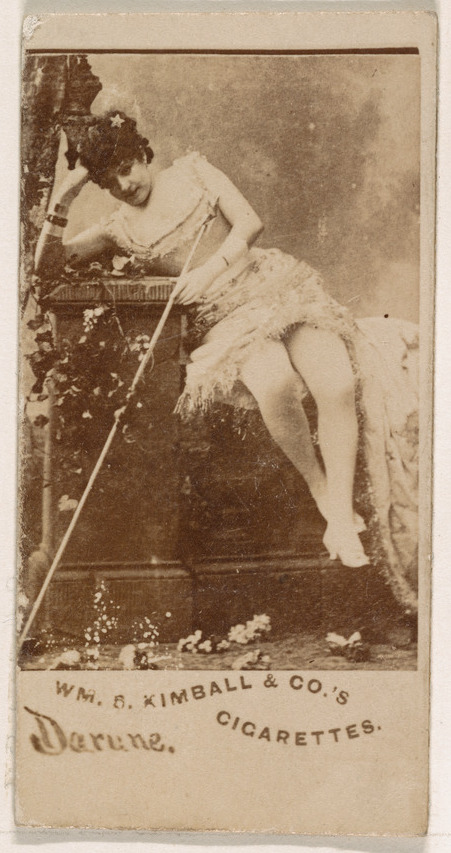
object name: photograph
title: Miss Darune, from the Actresses series (N203) issued by Wm. S. Kimball & Co.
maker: william s. kimball & company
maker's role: publisher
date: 1889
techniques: color lithograph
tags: portraits,women,actresses